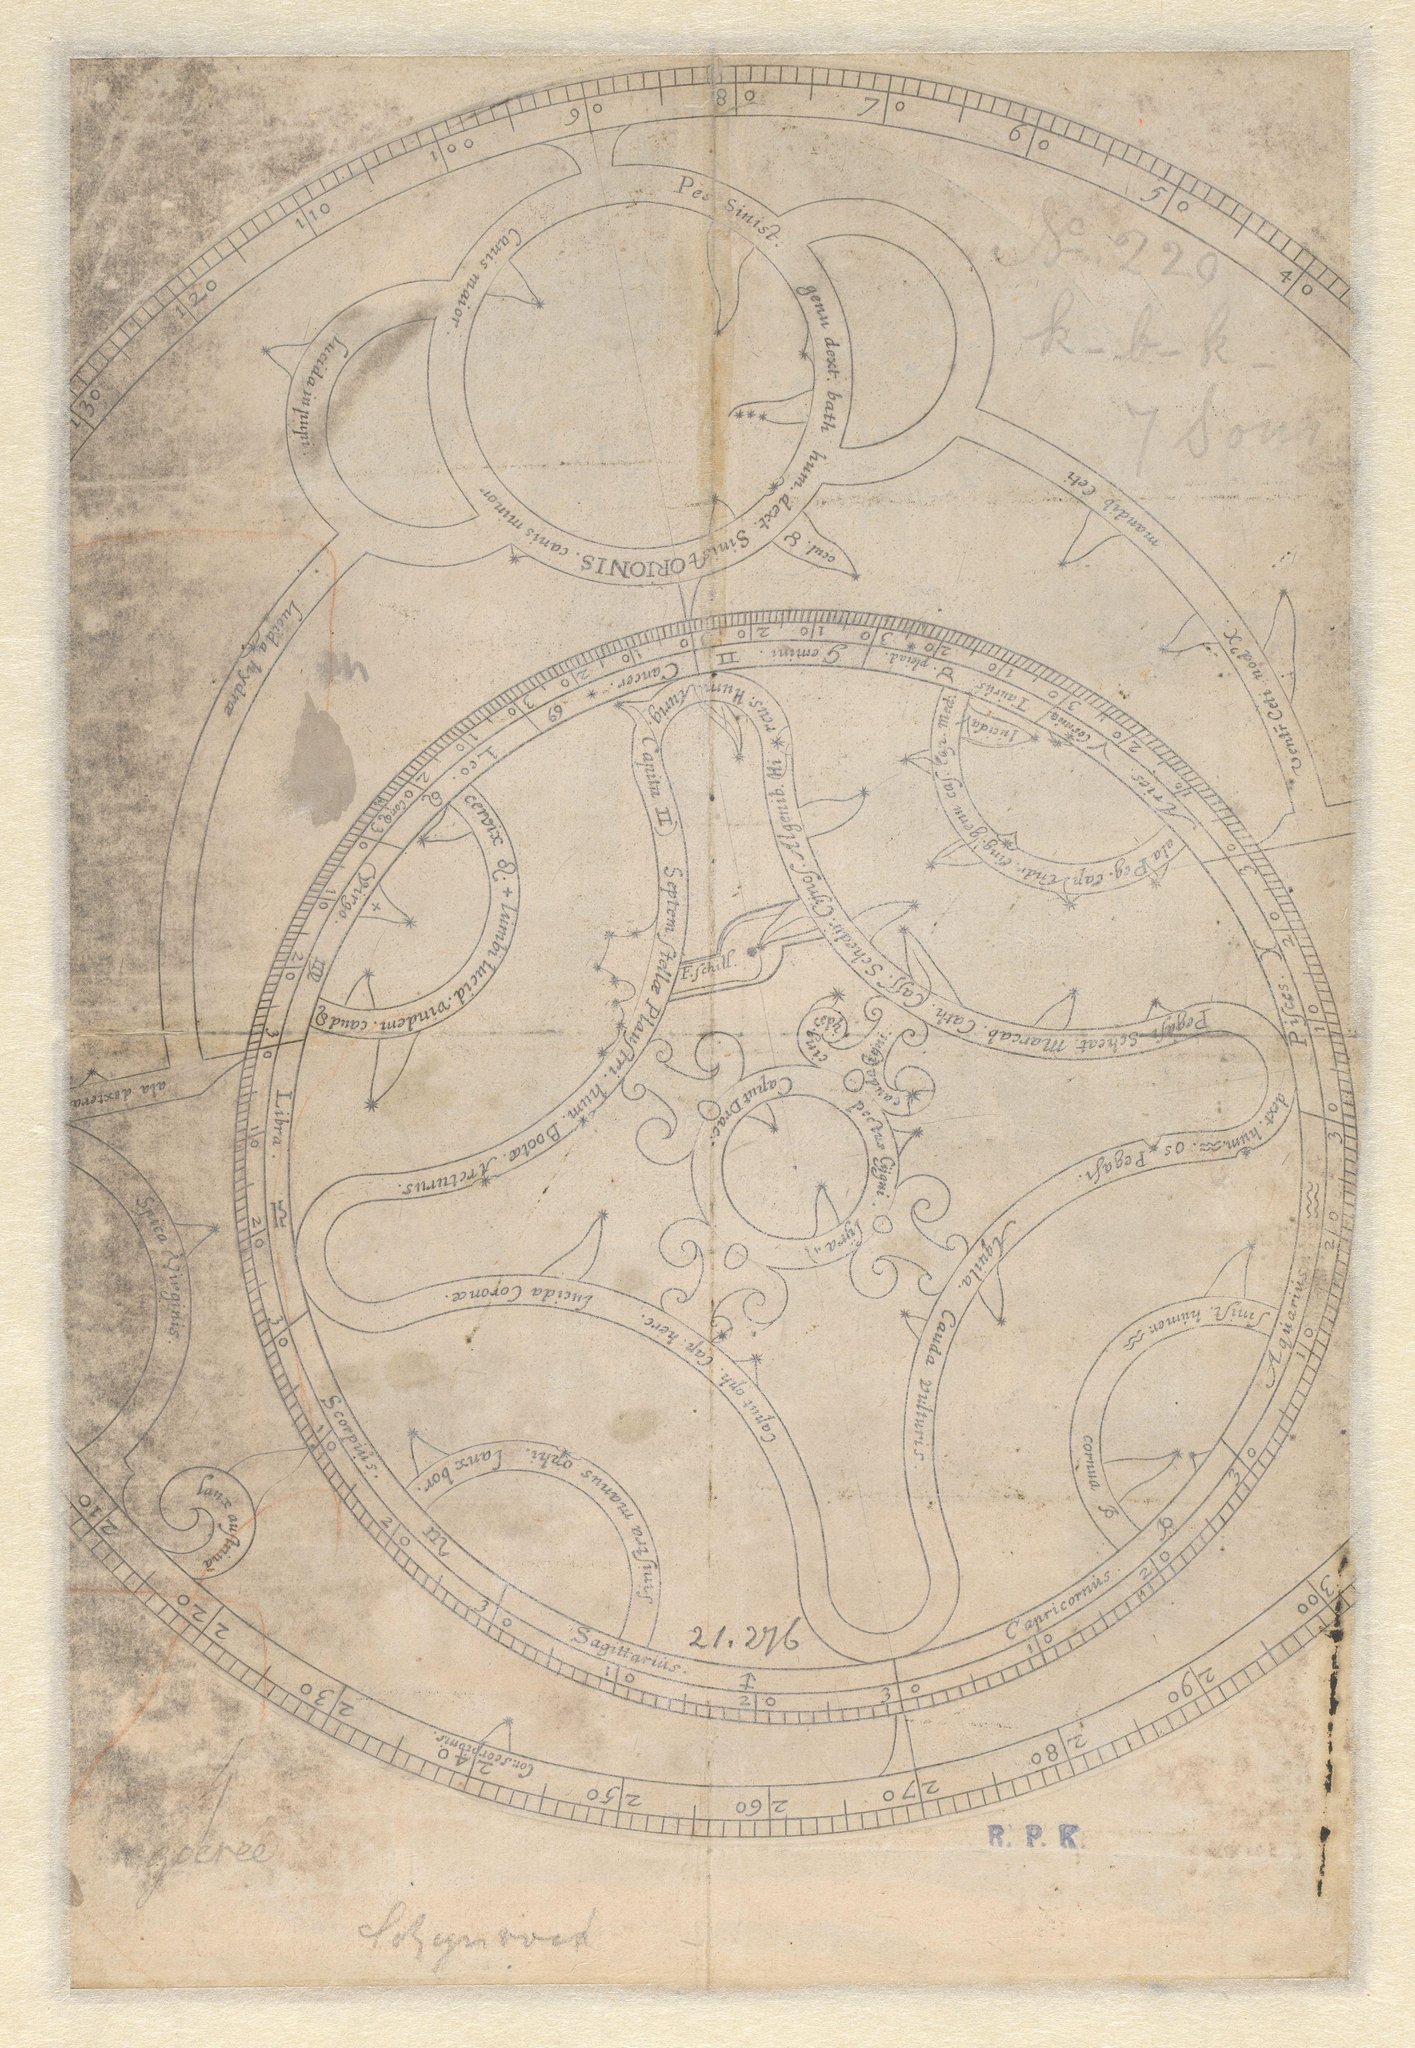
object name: print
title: Astrolabium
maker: Anonymous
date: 1600-1699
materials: paper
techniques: etching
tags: astrolabe